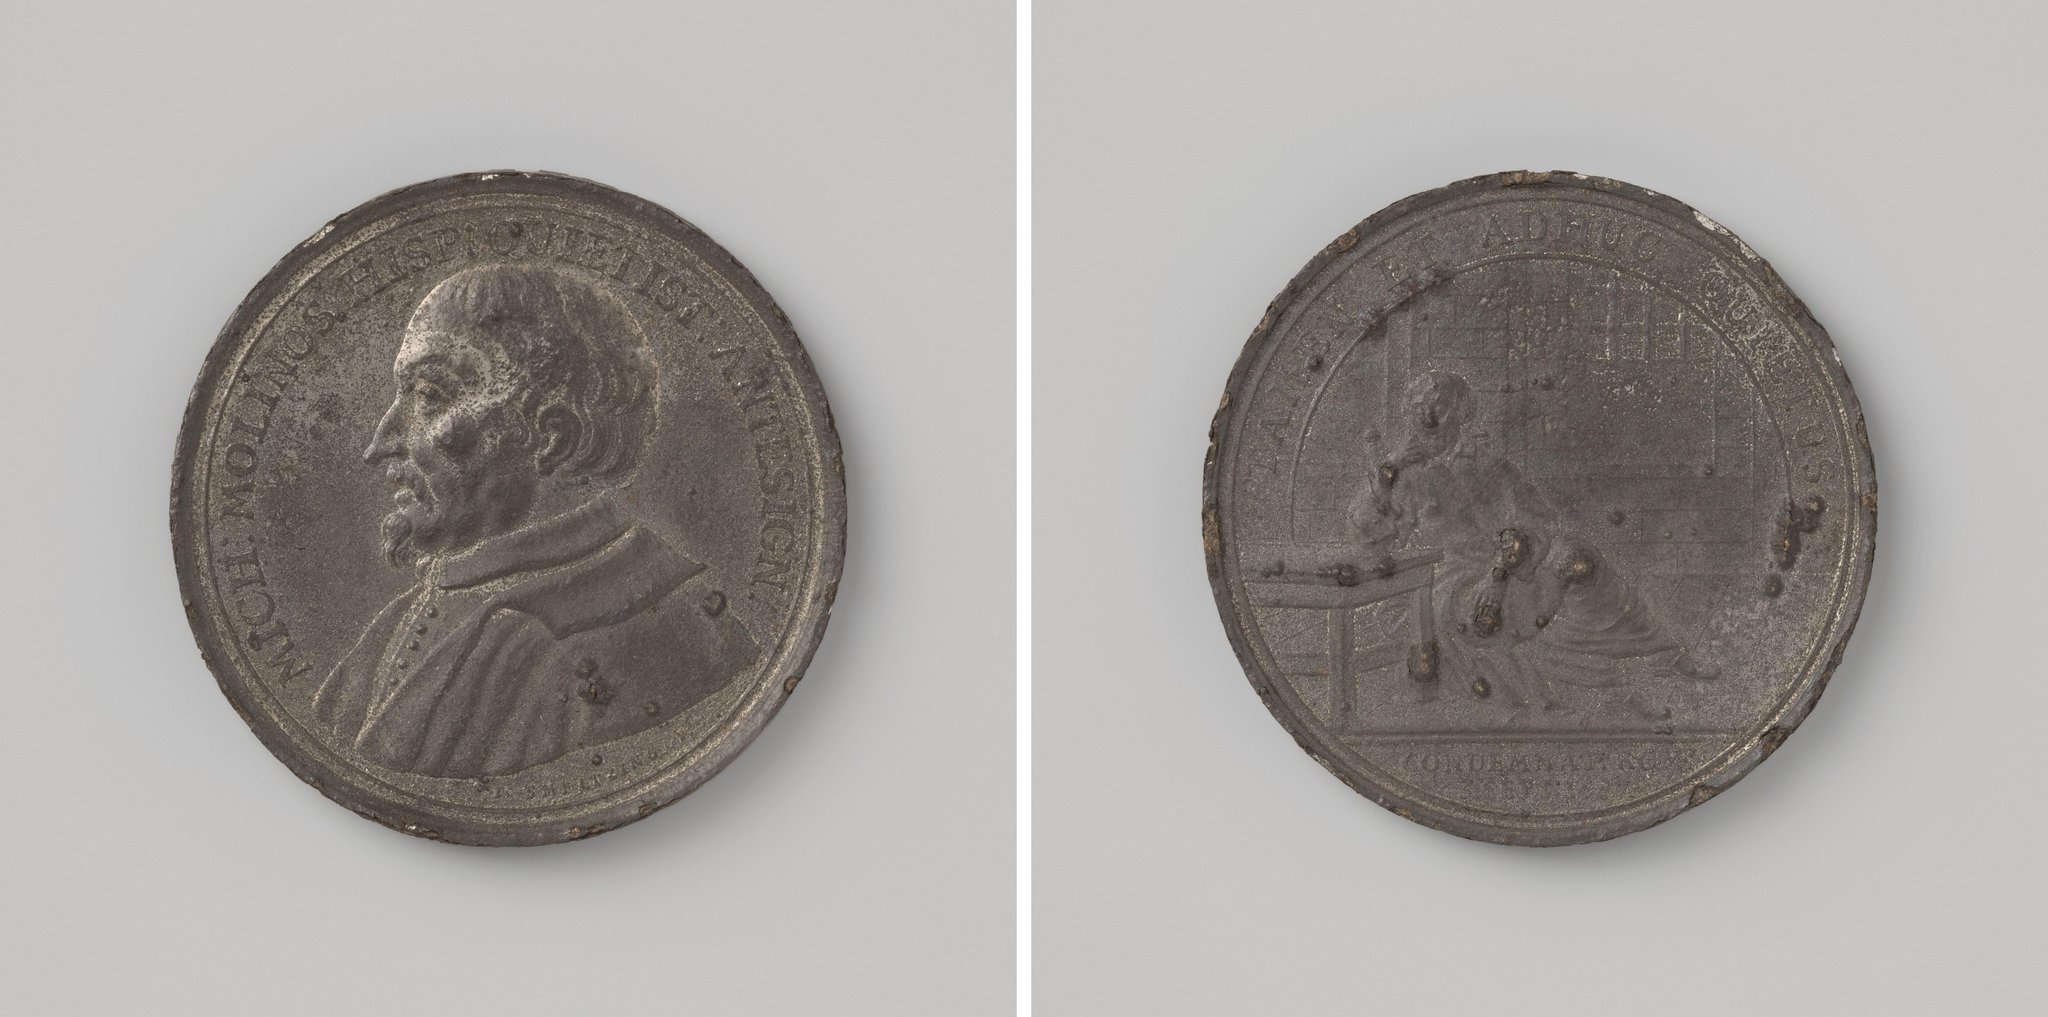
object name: copy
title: Michel Molinos, hoofd der Quietisten door Innocentius XI tot eeuwigdurende gevangenschap veroordeeld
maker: jan smeltzing (i)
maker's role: modelleur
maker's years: 1656-1693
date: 1687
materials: tin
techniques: striking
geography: leiden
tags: innocentius xi, rome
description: Tinnen penning. Voorzijde: borststuk man binnen omschrift. Keerzijde: zittende man met elleboog geleund op tafel, rechts venster met tralies; afsnede: opschrift.